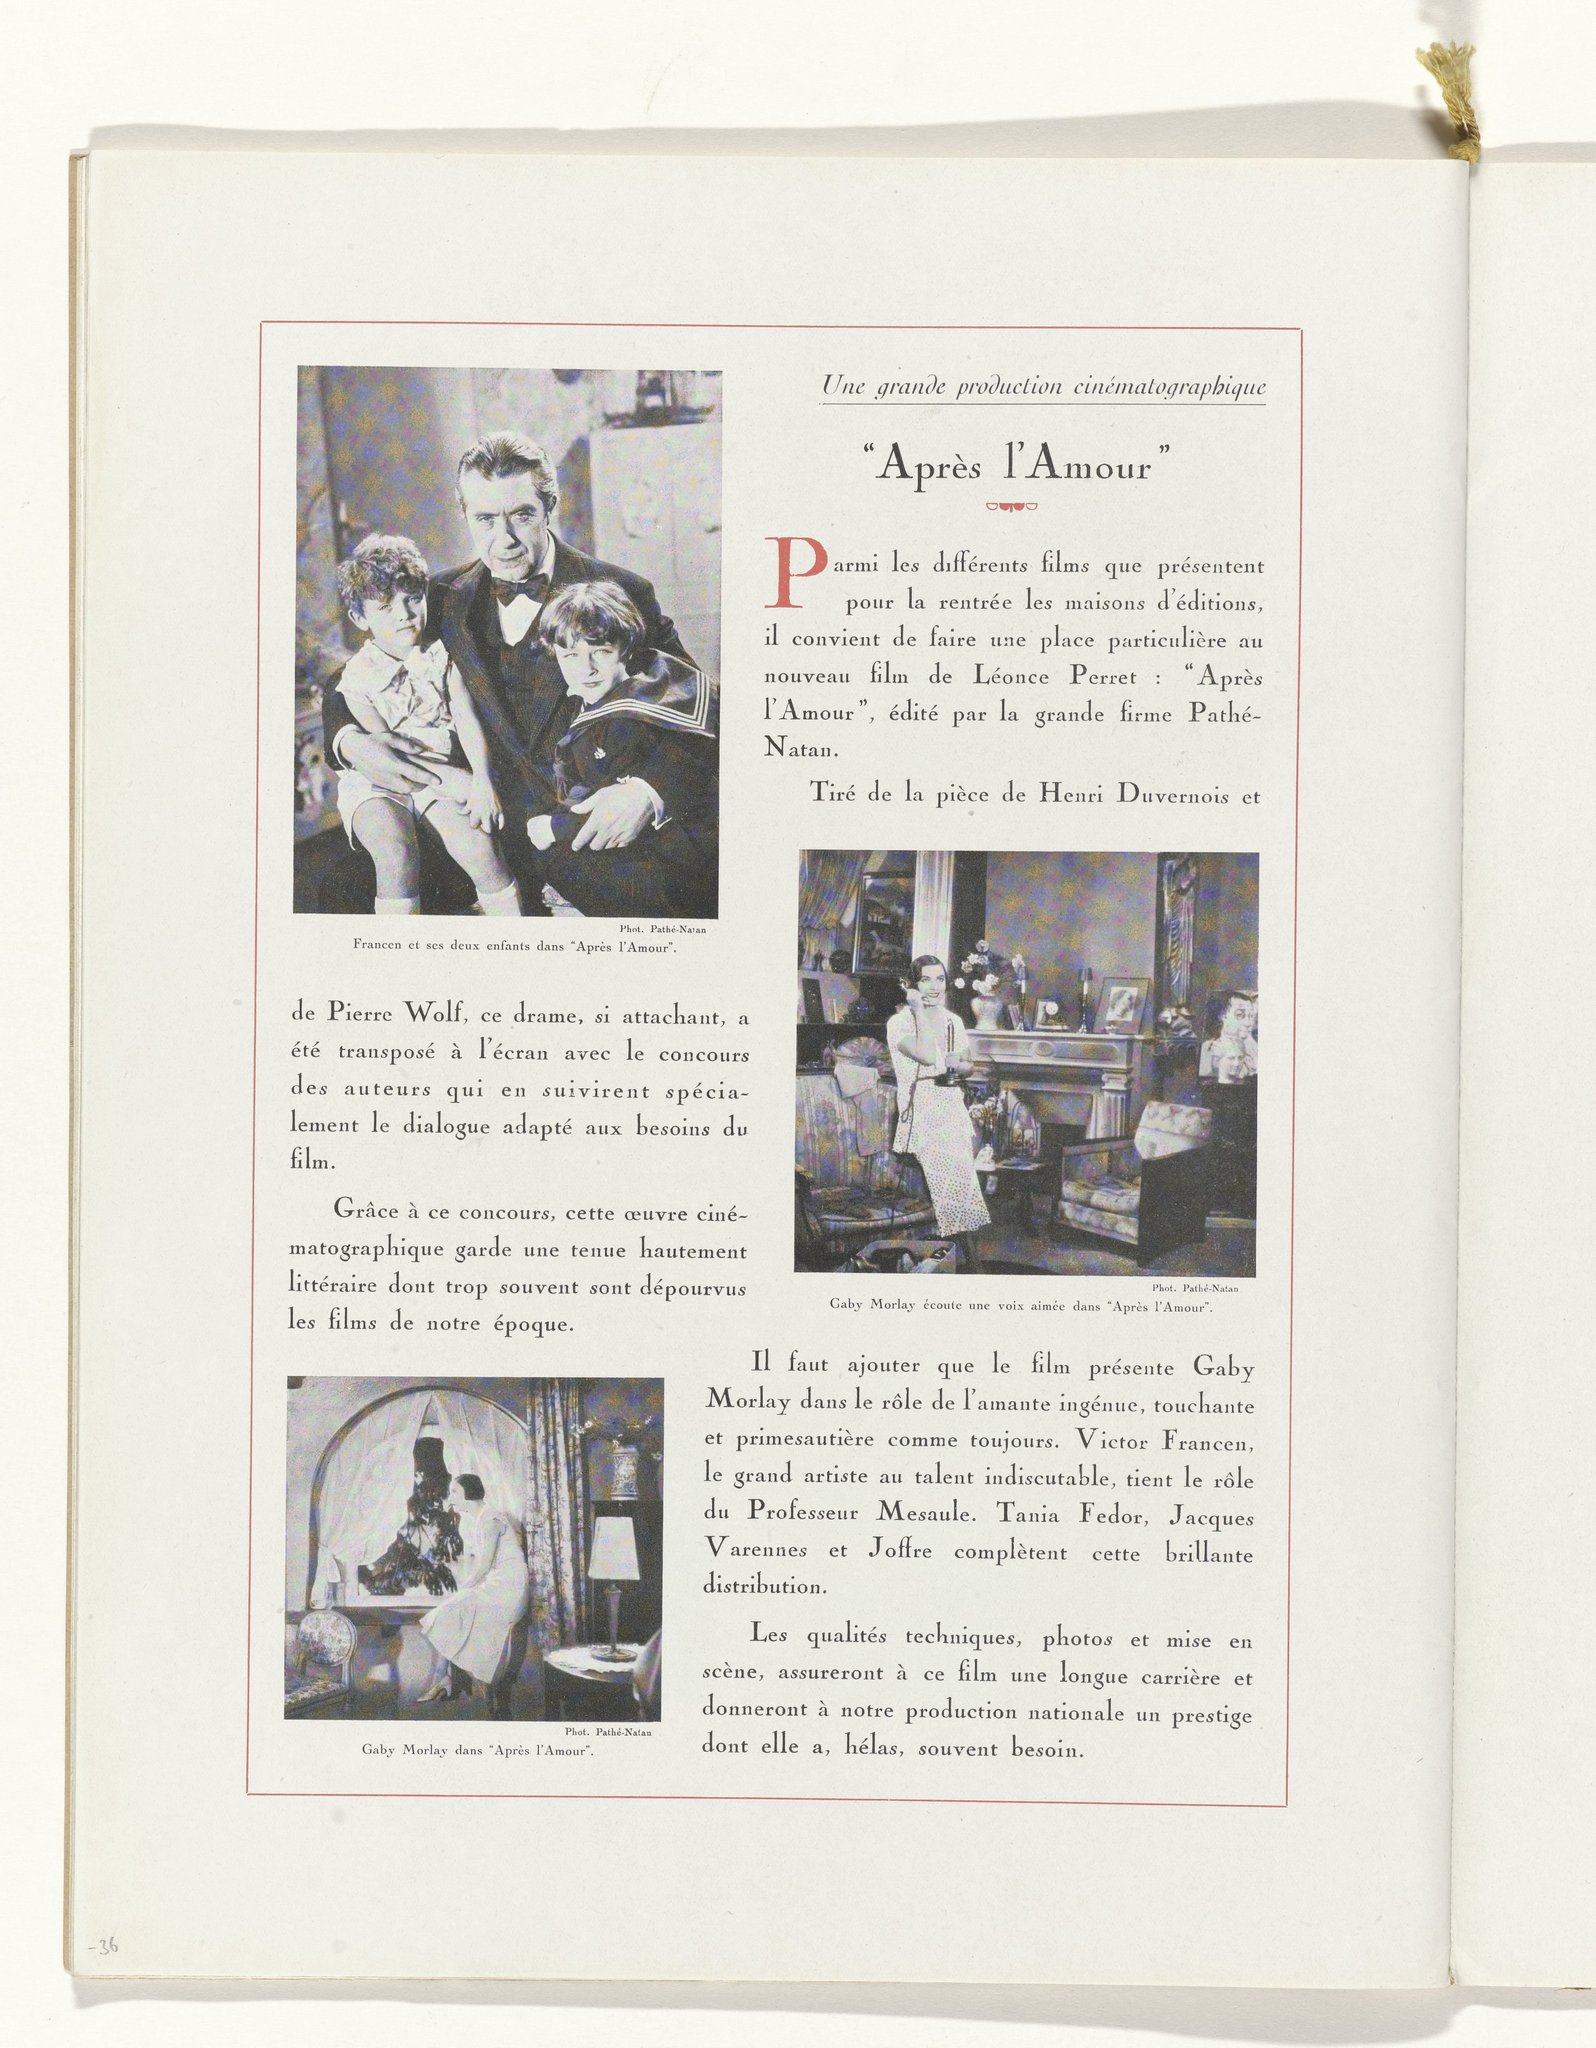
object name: magazine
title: Art - Goût - Beauté, Feuillets de l' élégance féminine, Novembre 1931, No. 135, 12e Année, p. 36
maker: charles goy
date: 1931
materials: paper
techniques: printing, photography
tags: fashion plates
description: Tekst 'Une grande production cinématographique " Après l Ámour"' met drie afbeeldingen uit de film. Pagina uit het modetijdschrift Art-Goût-Beauté (1920-1933).